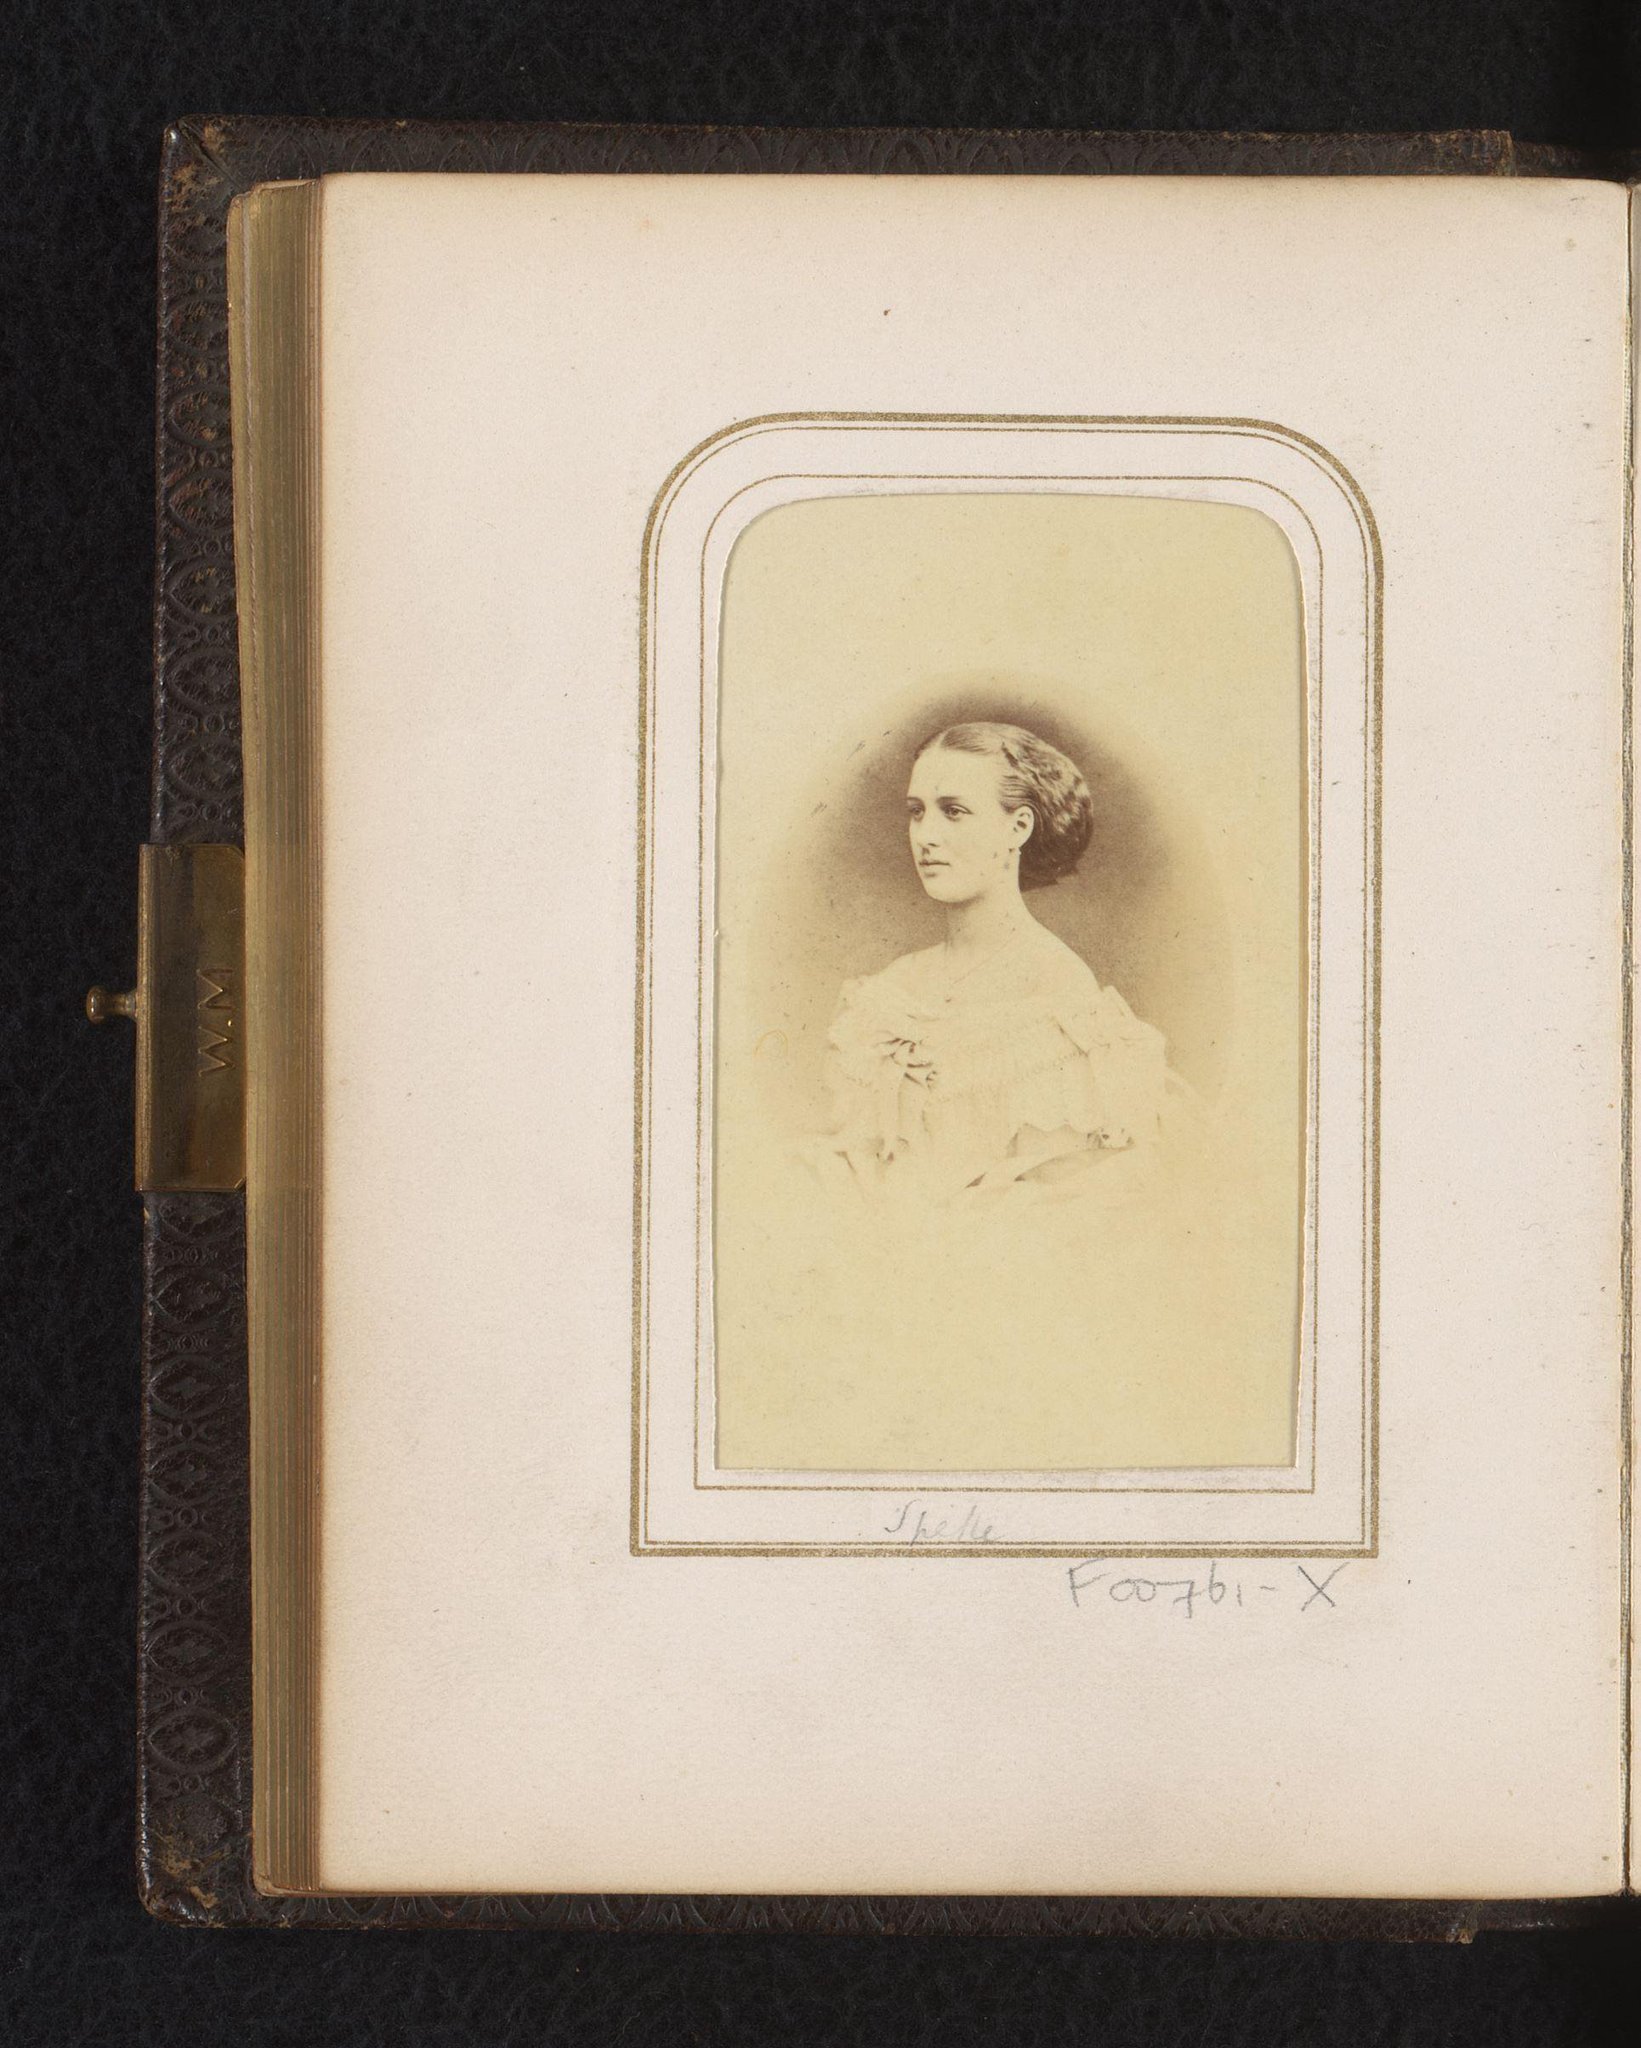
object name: carte de visite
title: Portret van een jonge vrouw, mogelijk Prinses Alexandra van Denemarken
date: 1860-1880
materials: cardboard, photographic support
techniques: albumen print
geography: copenhagen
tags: adolescent, young woman, maiden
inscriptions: inscription: ‘Rudolph Striegler/ Kongl. Hof-Photograph/ Kjöbenhavn/ Published by Fredc. Jones 146 Oxford St. London’, annotation: ‘[...]’